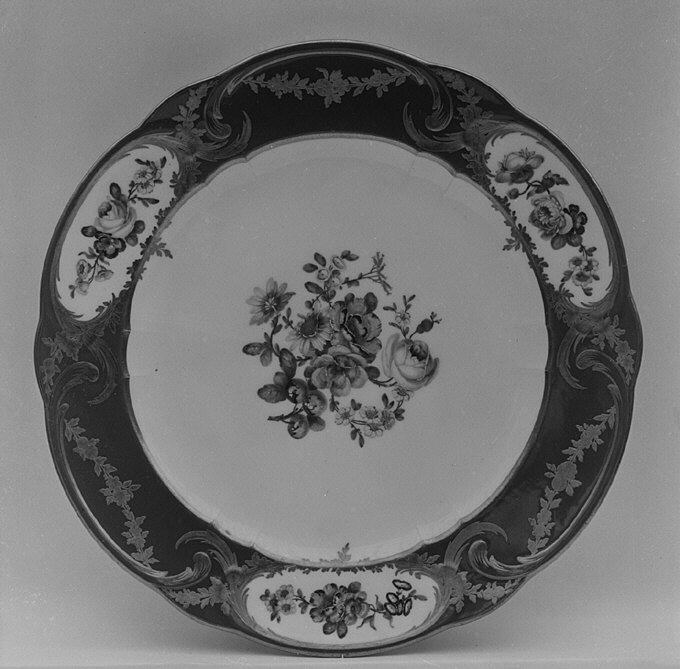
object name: plate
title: Plate (Assiette à palmes) (1 of 102) (part of a service)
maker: sèvres manufactory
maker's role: manufactory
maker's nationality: french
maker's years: 1740-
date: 1772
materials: soft paste porcelain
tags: flowers